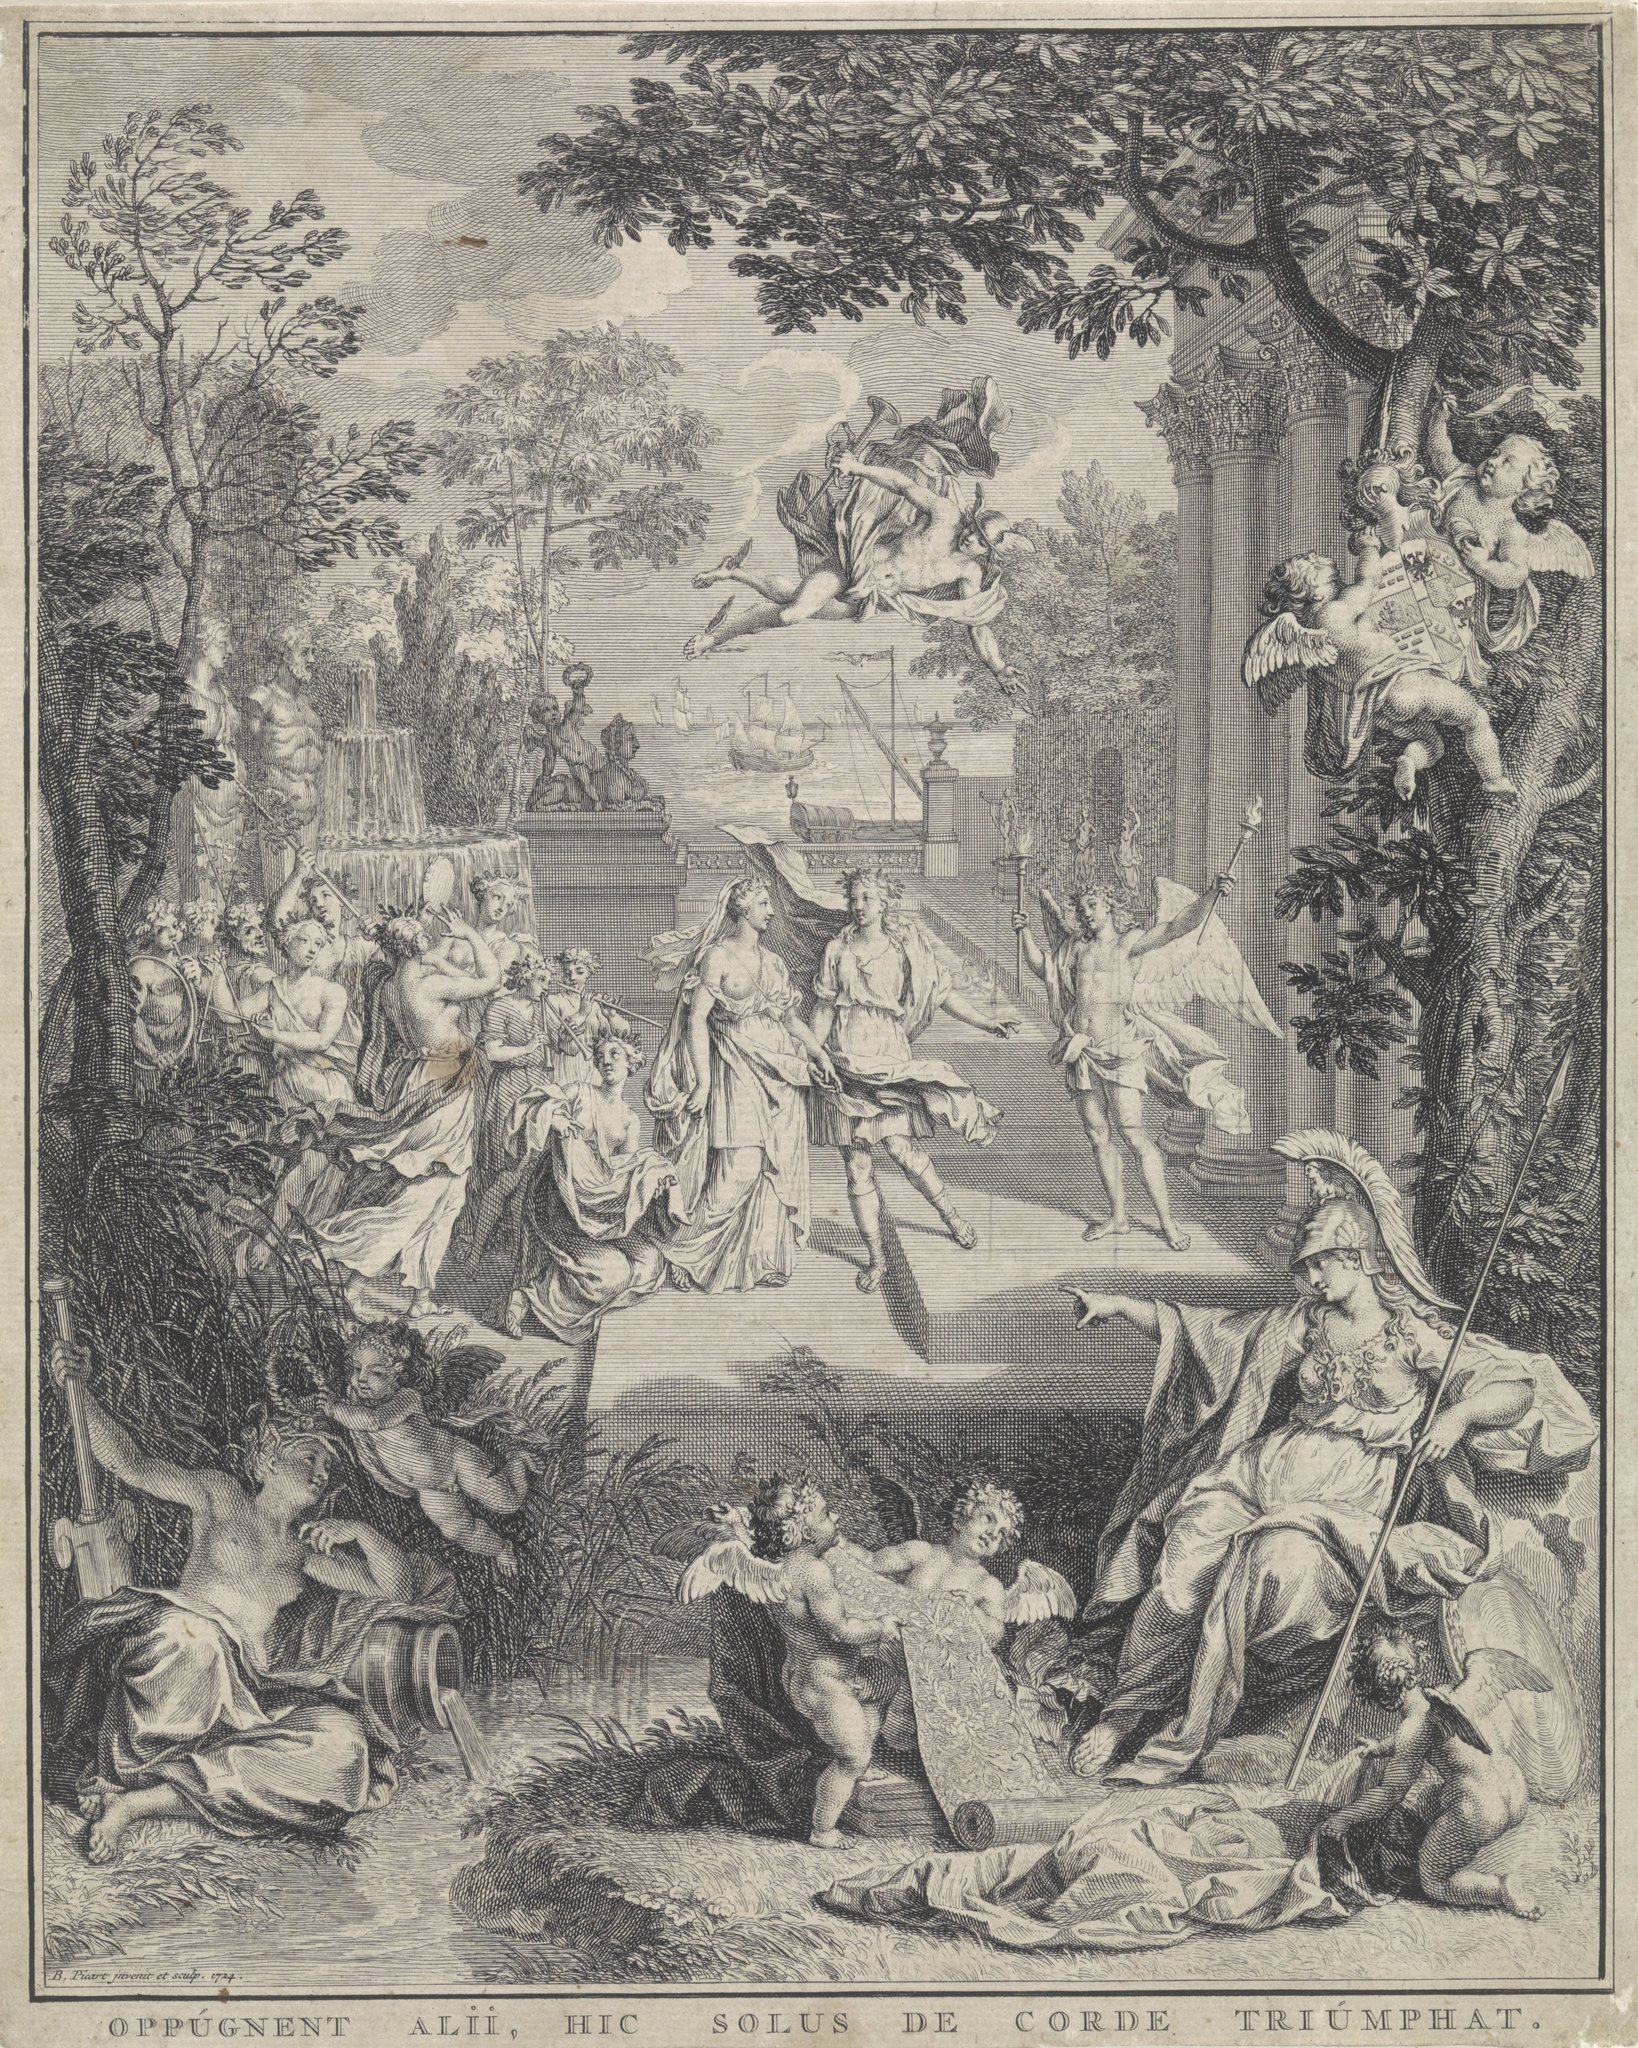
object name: marriage print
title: Allegorische voorstelling ter gelegenheid van het huwelijk van Abraham Barnaart en Engeltje van Hoven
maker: bernard picart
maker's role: draughtsman, print maker, publisher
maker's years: 1673-1733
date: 1724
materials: paper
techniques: engraving, etching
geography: amsterdam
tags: (story of) hymen(aeus), spirit of the air, sylph, (story of) minerva (pallas, athena), (story of) mercury (hermes), satyrs, fauns, sileni, marriage, married couple, 'matrimonium', faunus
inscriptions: collector's mark: Lugt 2228, signature: ‘B. Picart invenit et sculp. 1724’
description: Allegorische voorstelling ter gelegenheid van het huwelijk van Abraham Barnaart en Engeltje van Hoven op 28 maart 1724 te Haarlem. De huwelijksgod Hymen staat voor zijn tempel en ontvangt het paar en haar gevolg van nimfen, faunen en maenaden. Boven in de lucht zweeft de handelsgod Mercurius. Rechts zit Minerva, die op het paar wijst. Putti tonen haar stoffen, die de handel van het echtpaar in stoffen symboliseert. Onder de voorstelling het devies: Oppugnent Alii Hic Solus De Corde Triumphat.